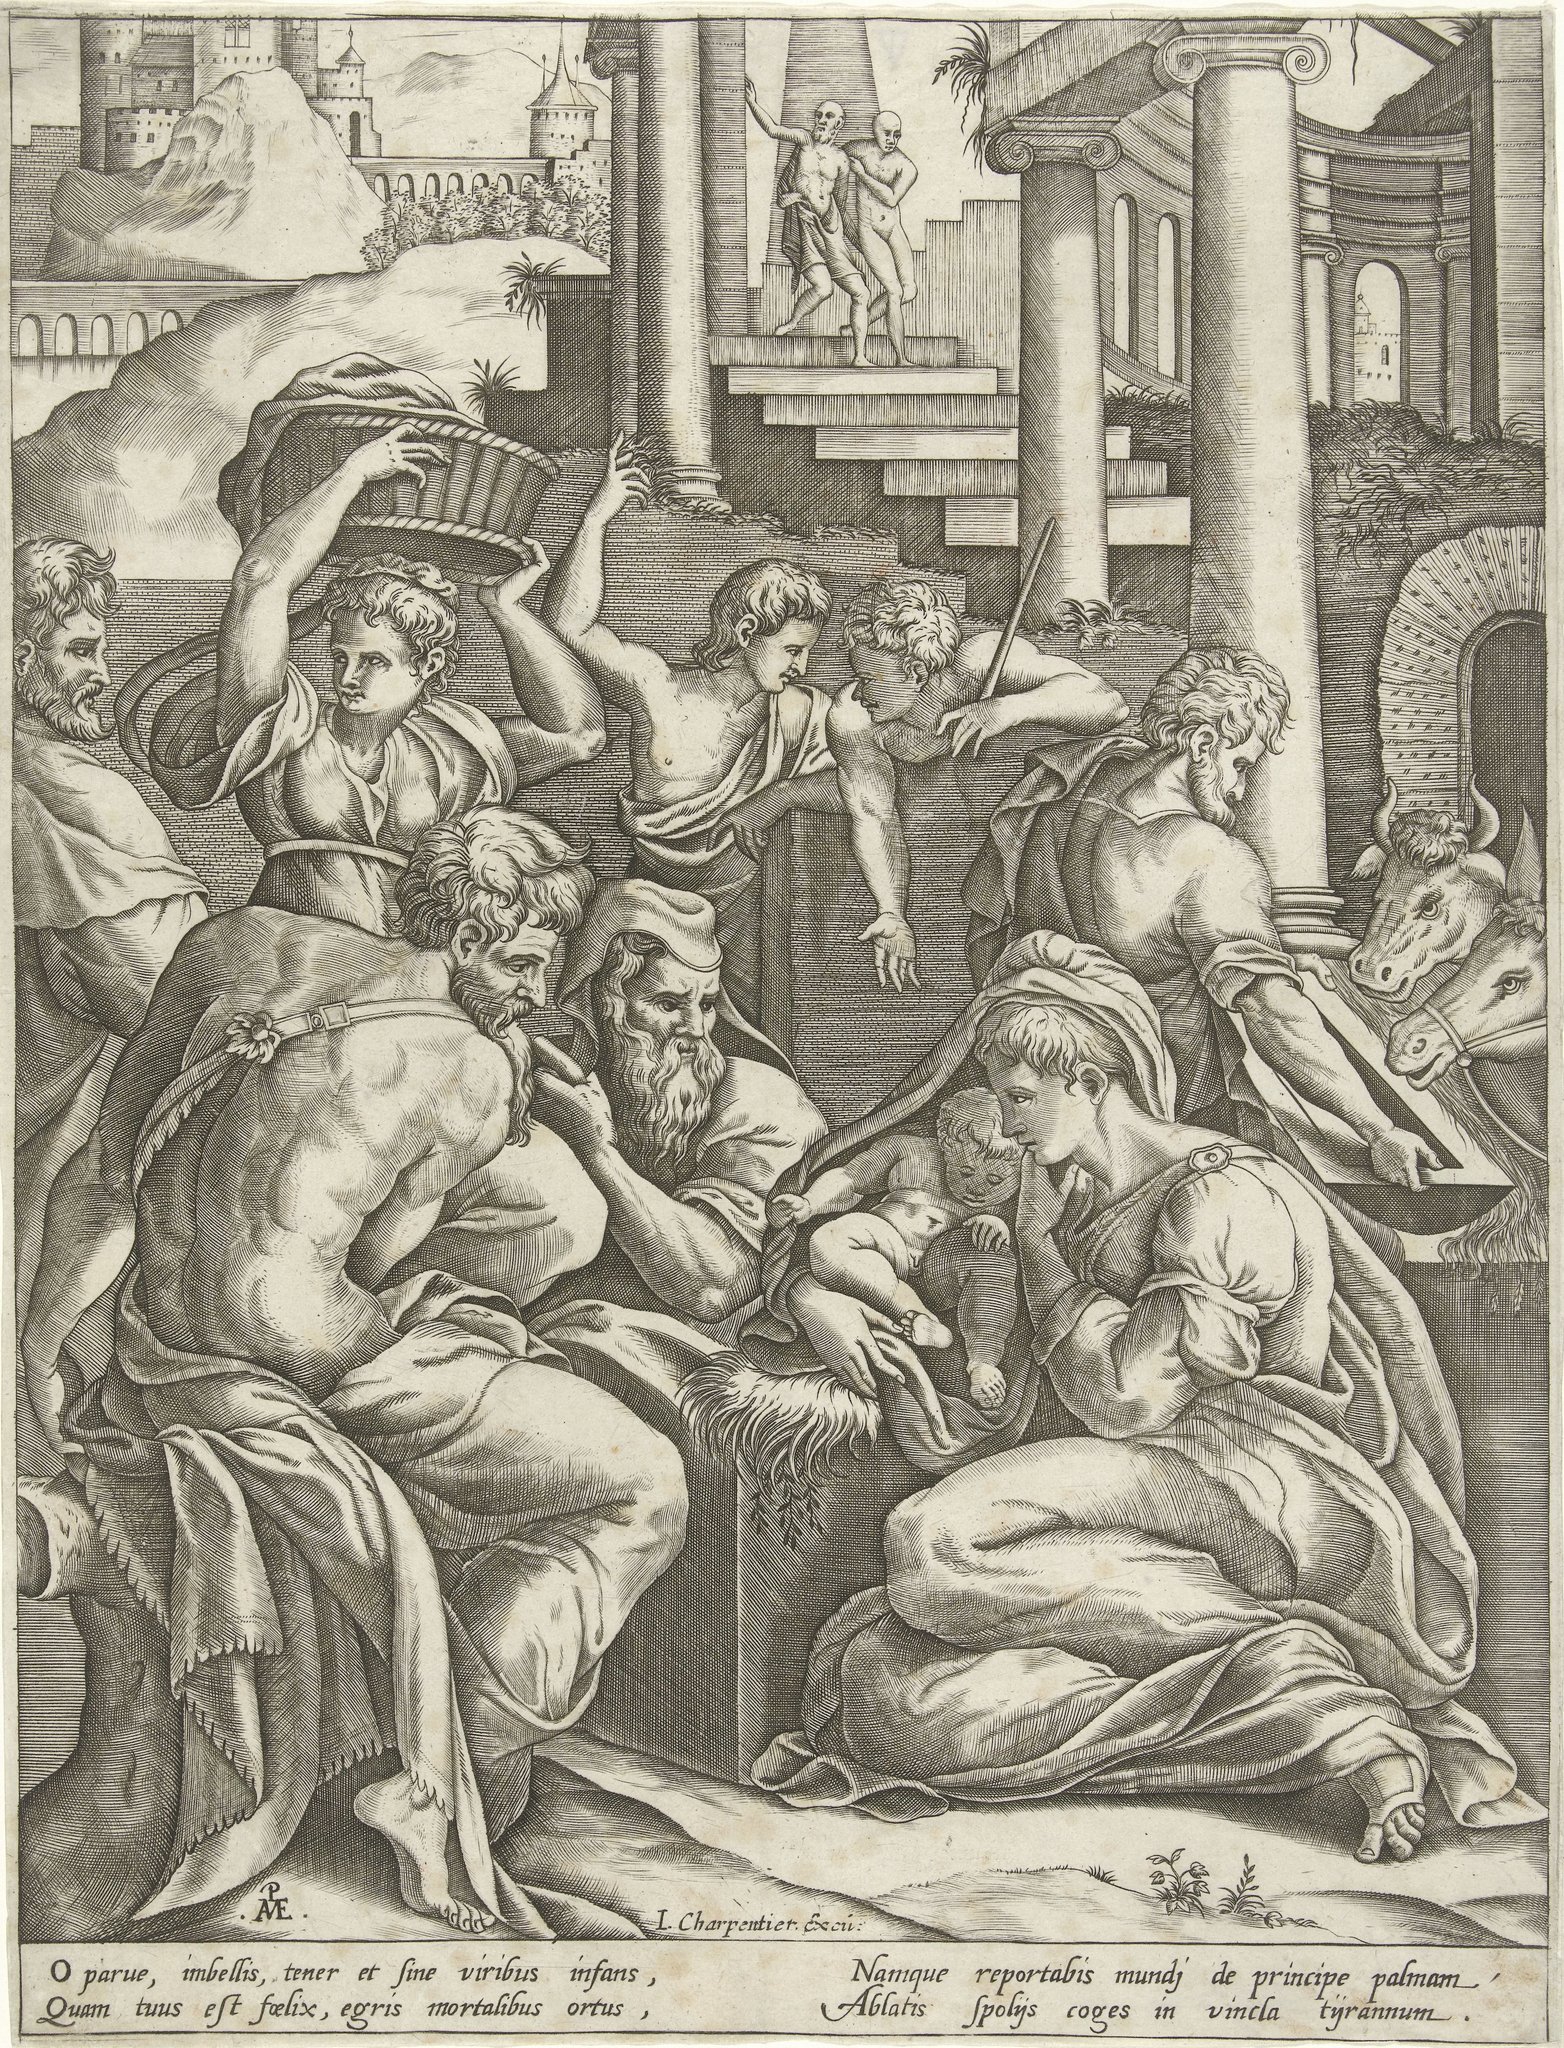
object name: print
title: Aanbidding door de herders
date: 1633-1634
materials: paper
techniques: engraving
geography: amsterdam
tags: adoration of the christ-child by the shepherds; mary and joseph present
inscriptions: collector's mark: Lugt 240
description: Aan de voet van een klassiek bouwwerk aanbidden de herders het Christuskind, vastgehouden door een op de grond zittende Maria. Links van het Kind, eveneens zittend, Jozef met zijn staf. In de achtergrond een gedeelte van een kasteel op een rots en twee mannen die een trap afdalen. Onder de voorstelling vier Latijnse verzen in twee kolommen.